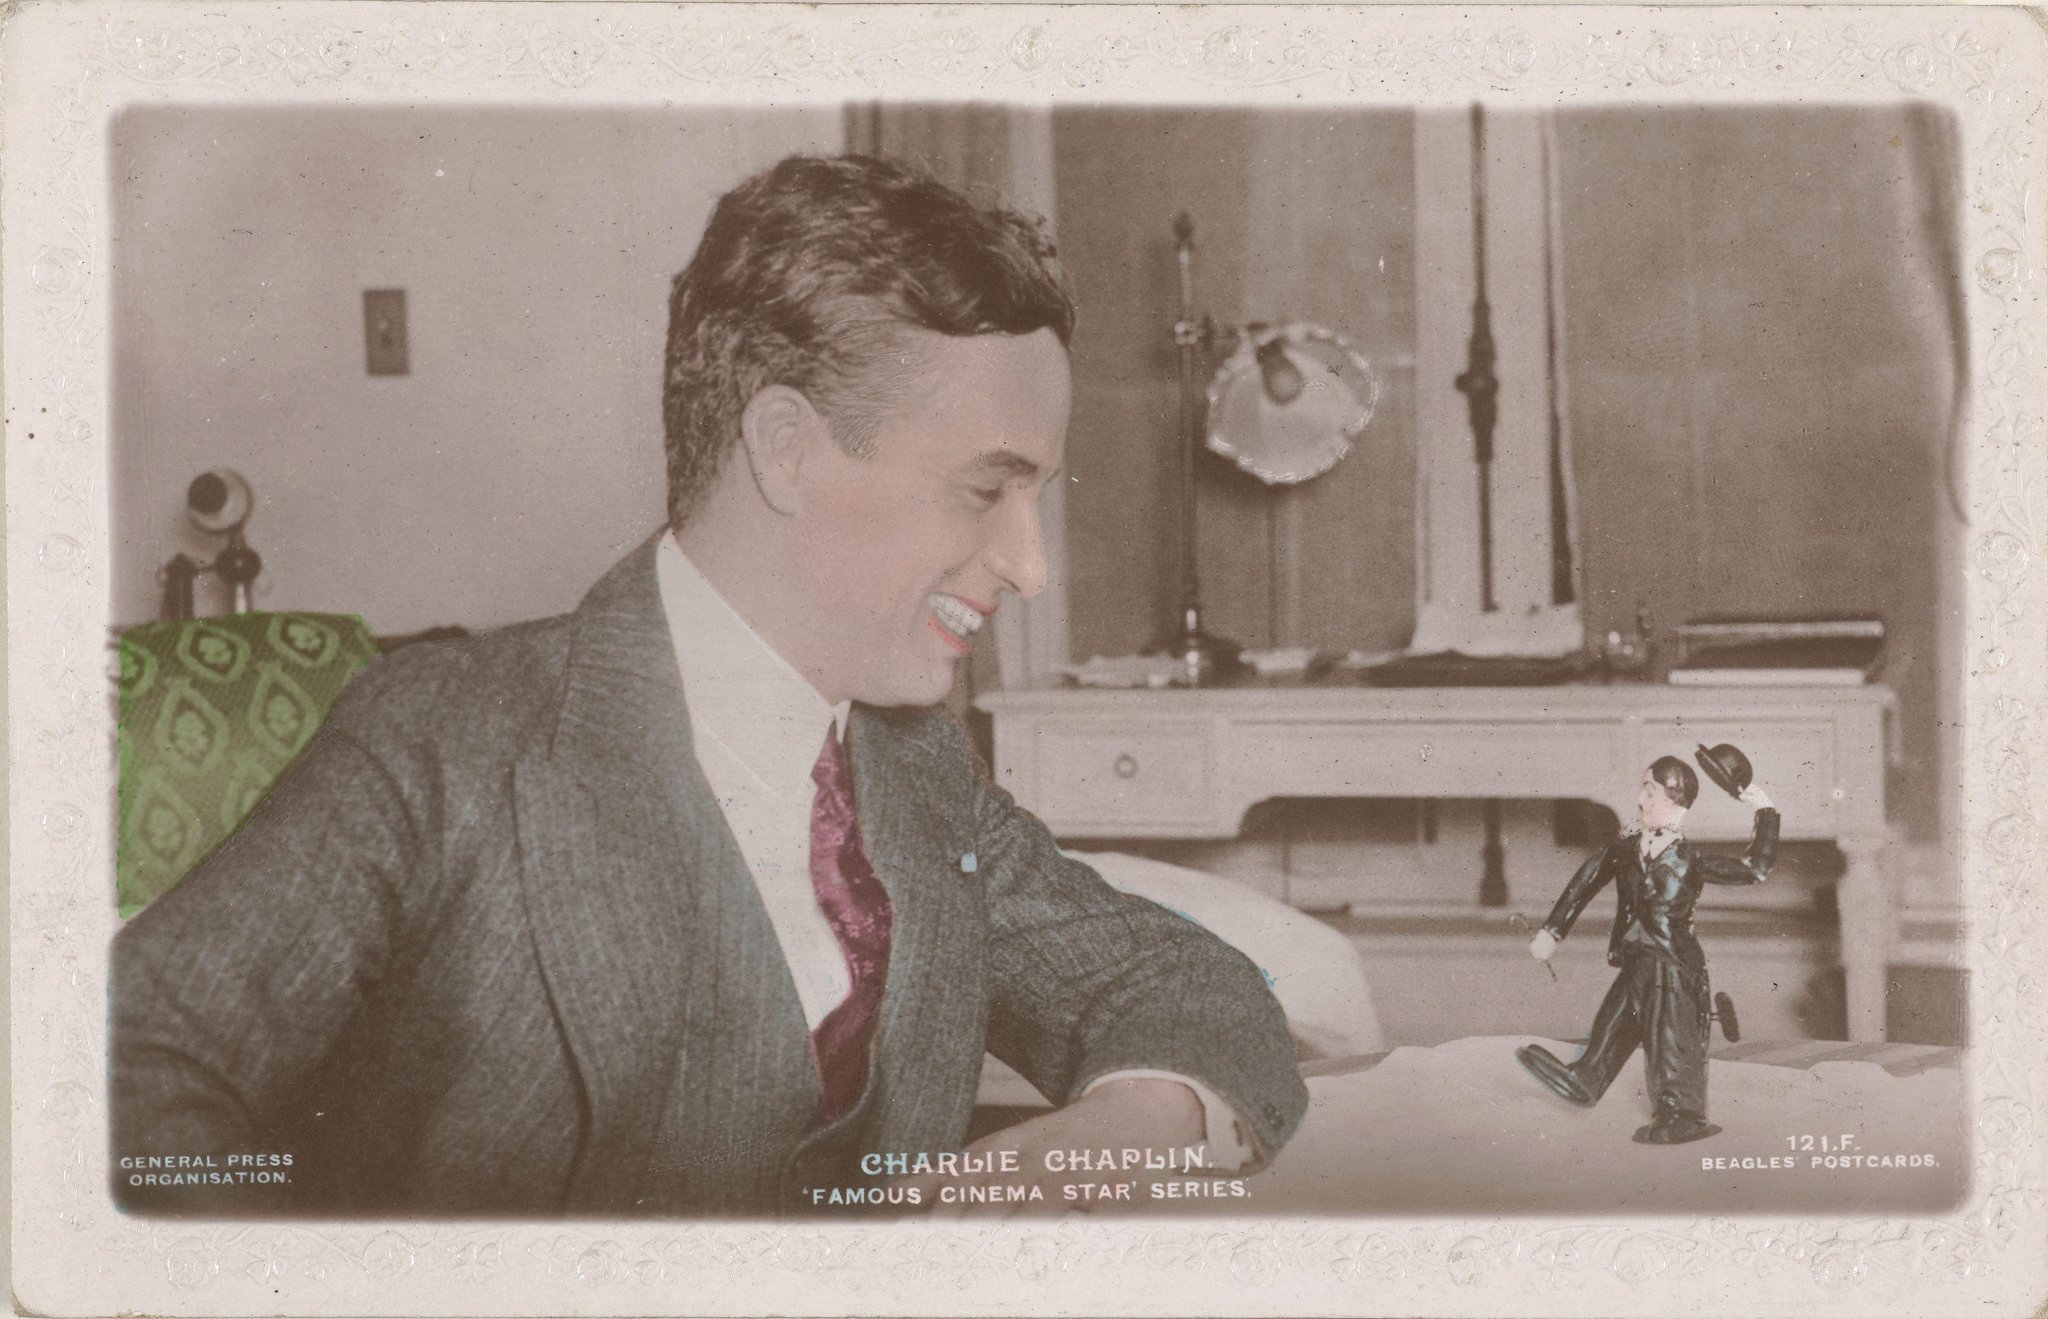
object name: photograph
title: Charlie Chaplin famous cinema star series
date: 1900-1950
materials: photographic support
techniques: gelatin silver print, hand coloring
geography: london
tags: acteur, charlie chaplin